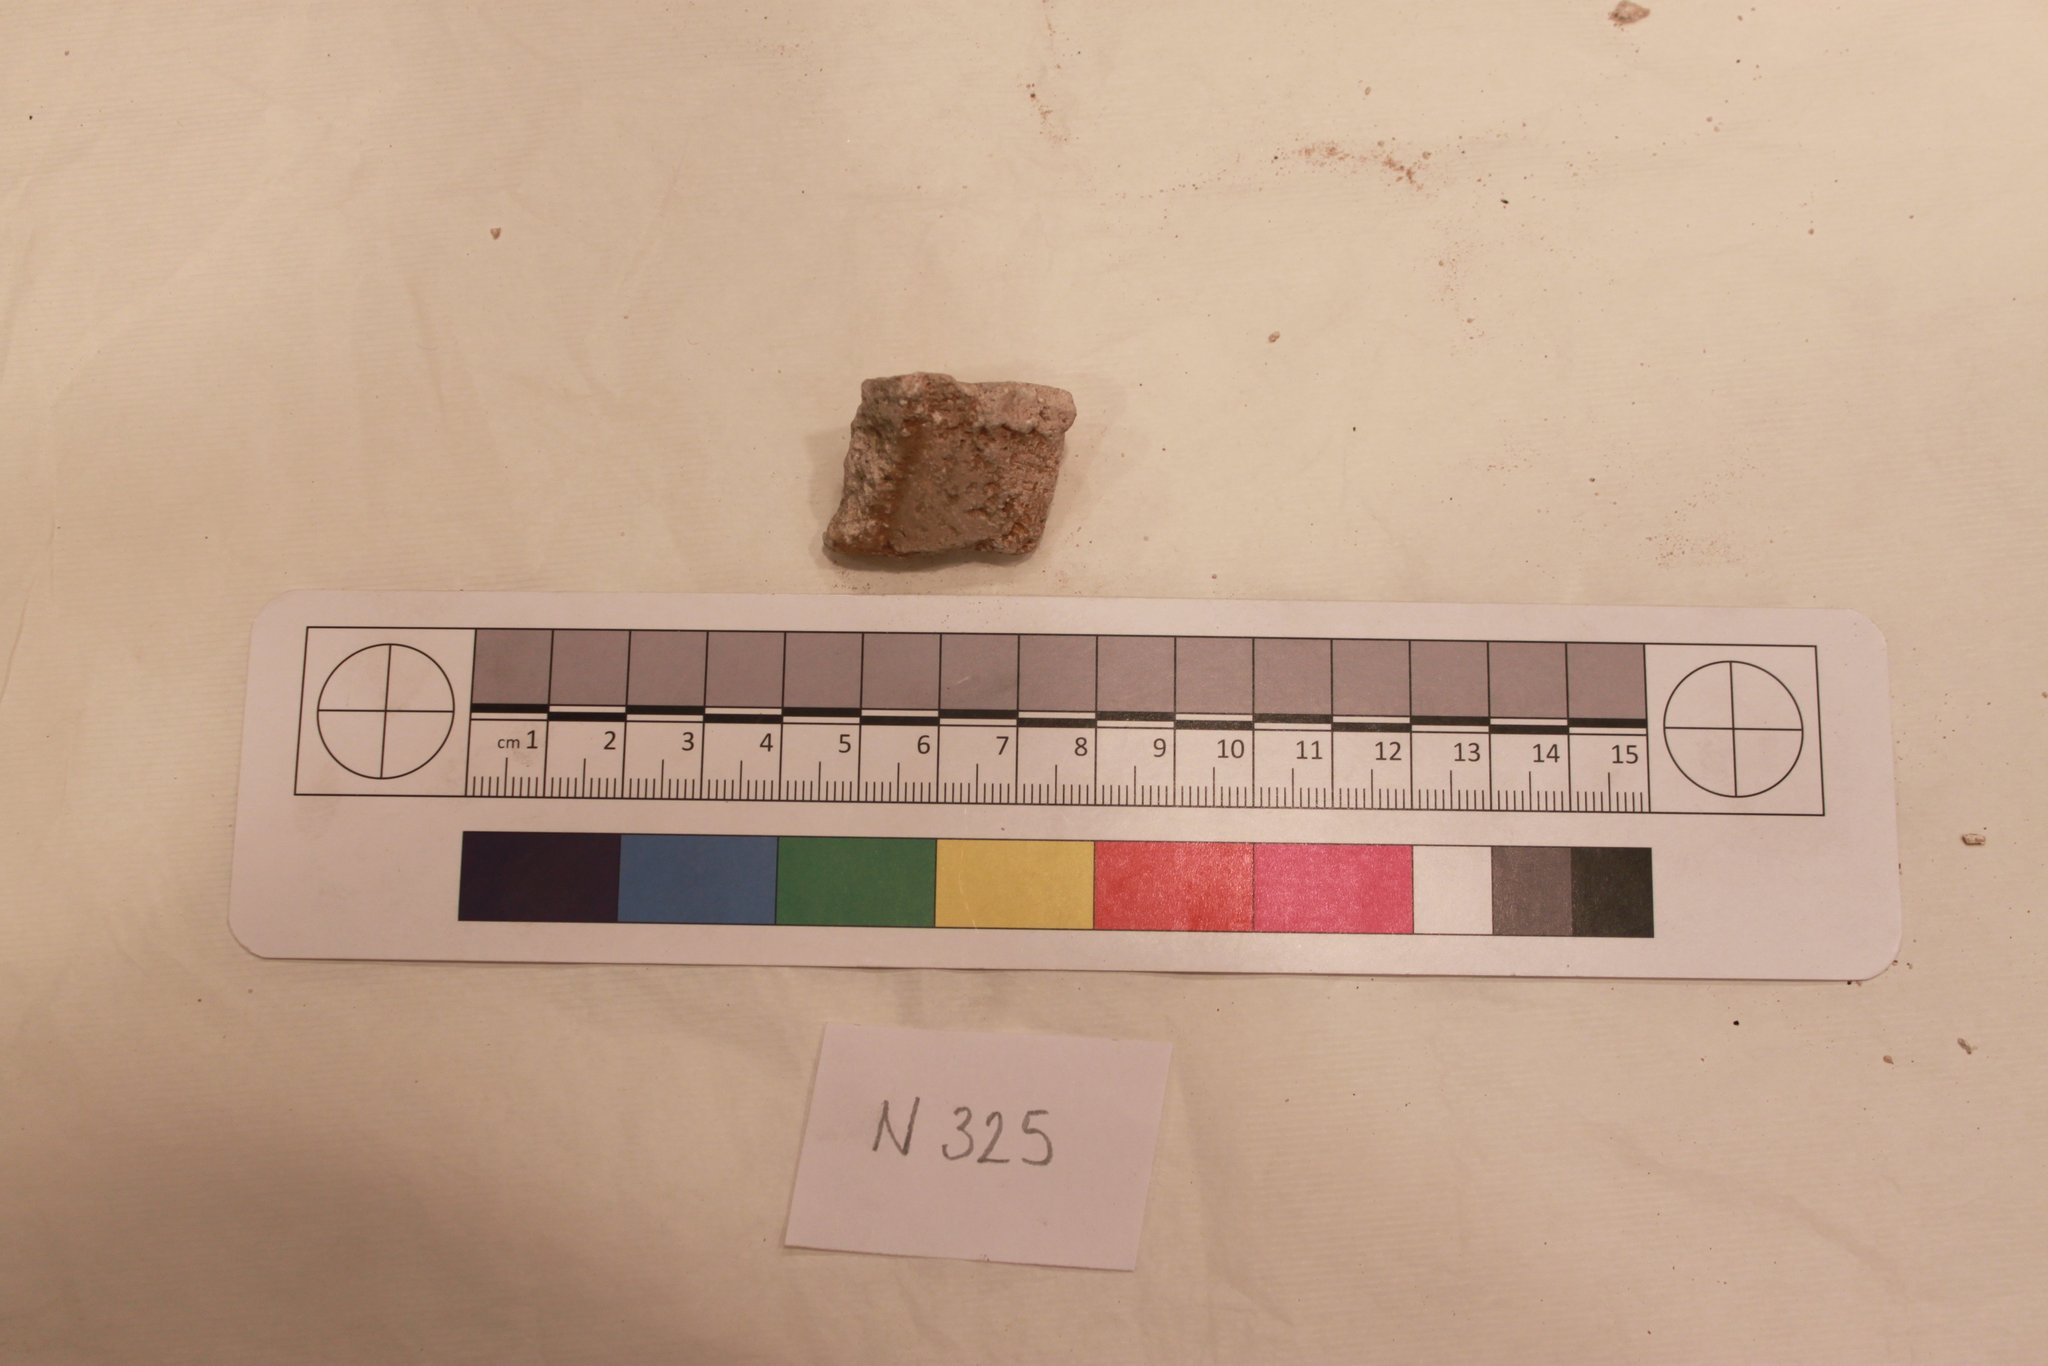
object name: fragment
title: Stucco Fragment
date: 701-1200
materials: plaster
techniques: carving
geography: iran